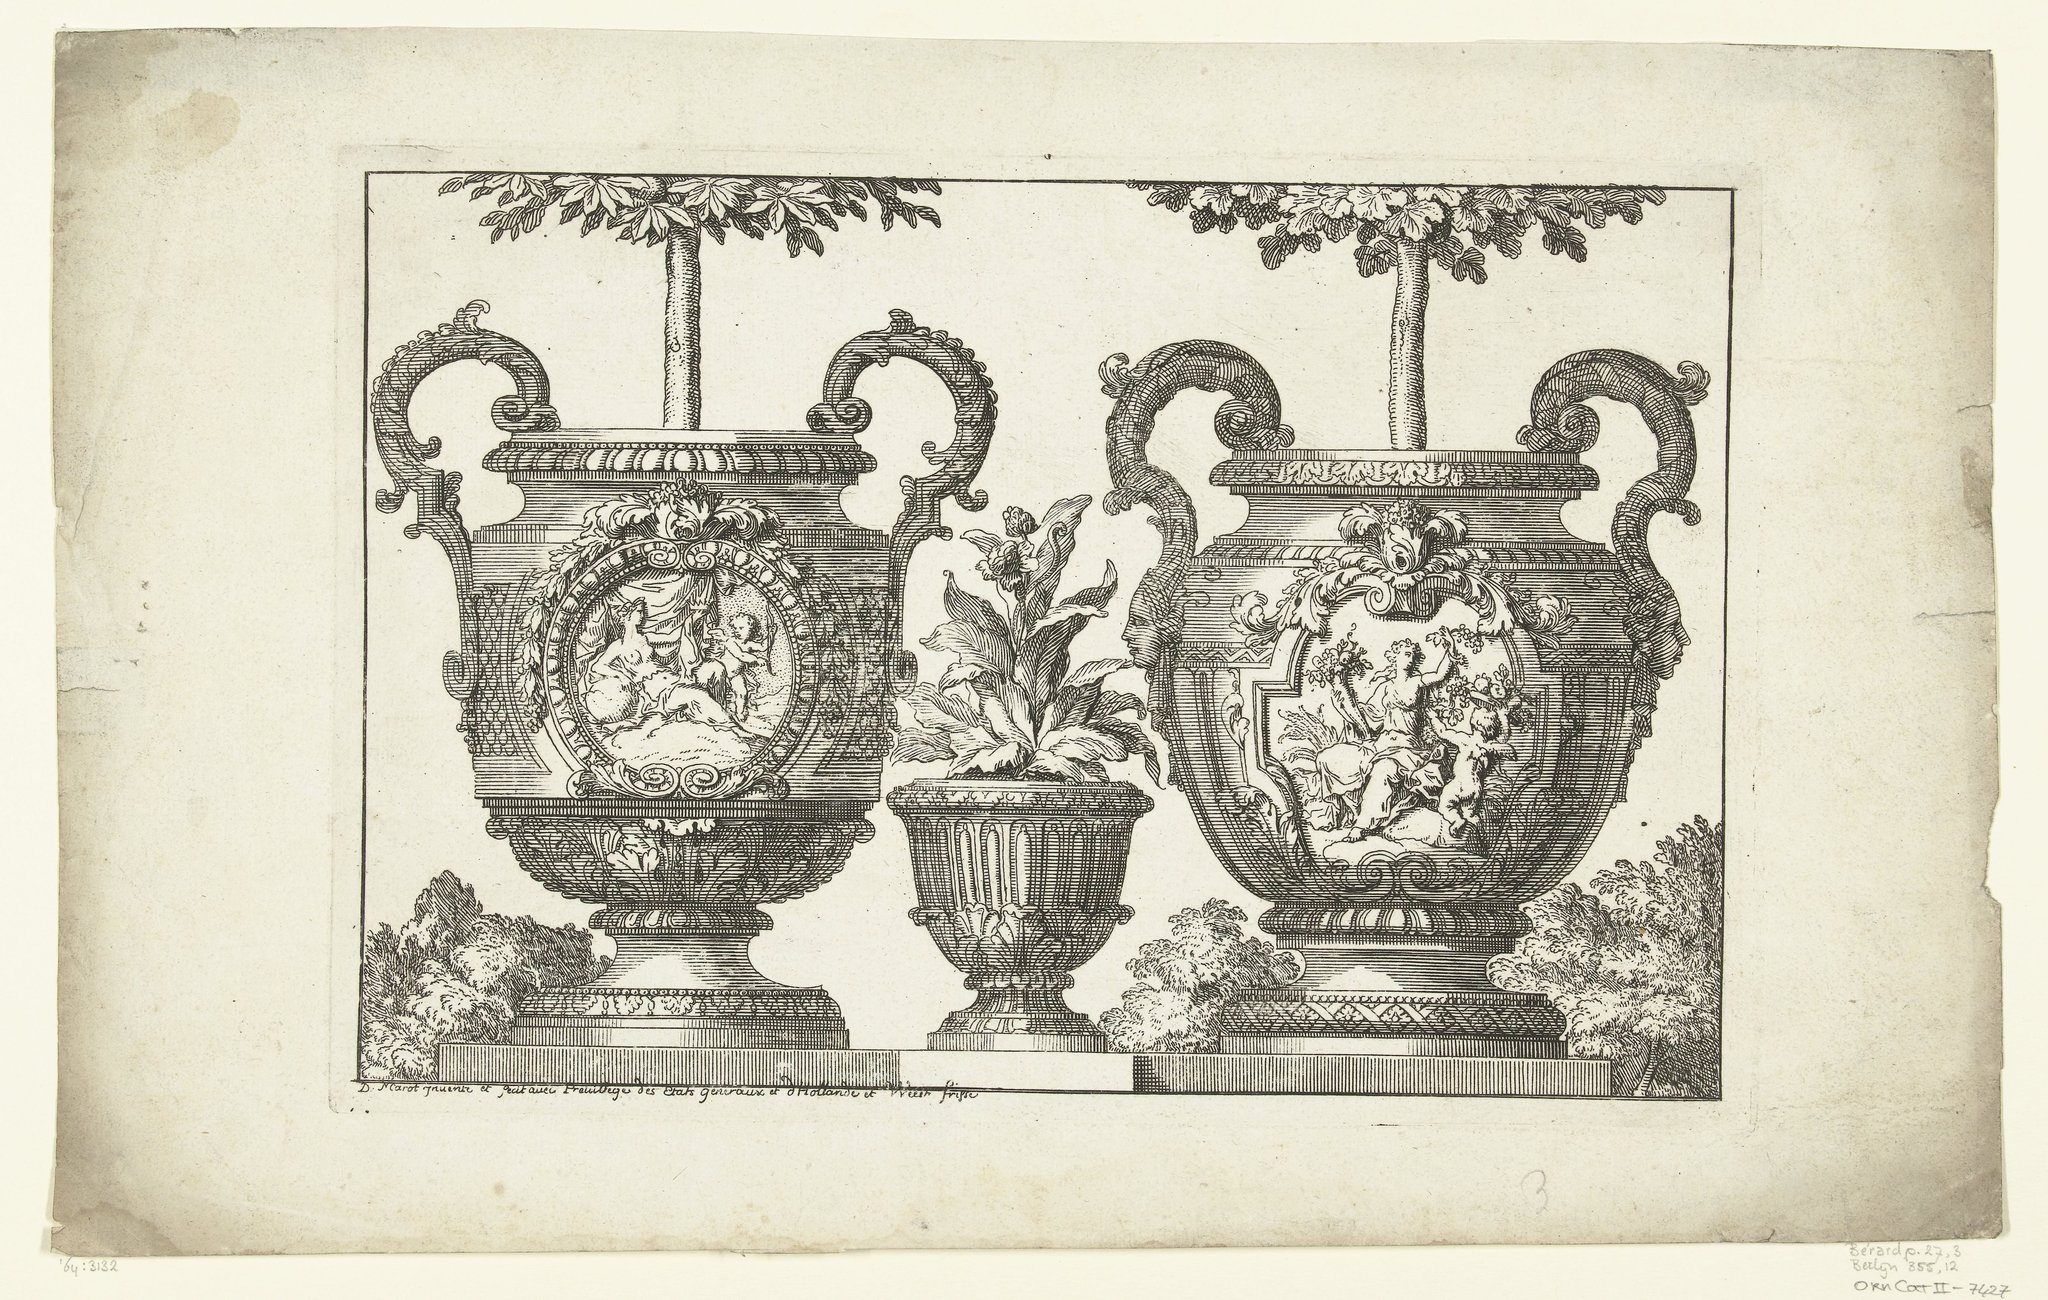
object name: print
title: Twee grote vazen en een kleine vaas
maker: daniël marot (i)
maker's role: draughtsman, print maker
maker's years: 1661-1752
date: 1673-1703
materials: paper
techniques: etching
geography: netherlands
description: Op de vaas links staat een medaillon met Venus en Cupido, op de vaas rechts een medaillon met Cupido en Overvloed. In de grote vazen staan boompjes, in de kleine staat een plant. Uit serie van 6 bladen.